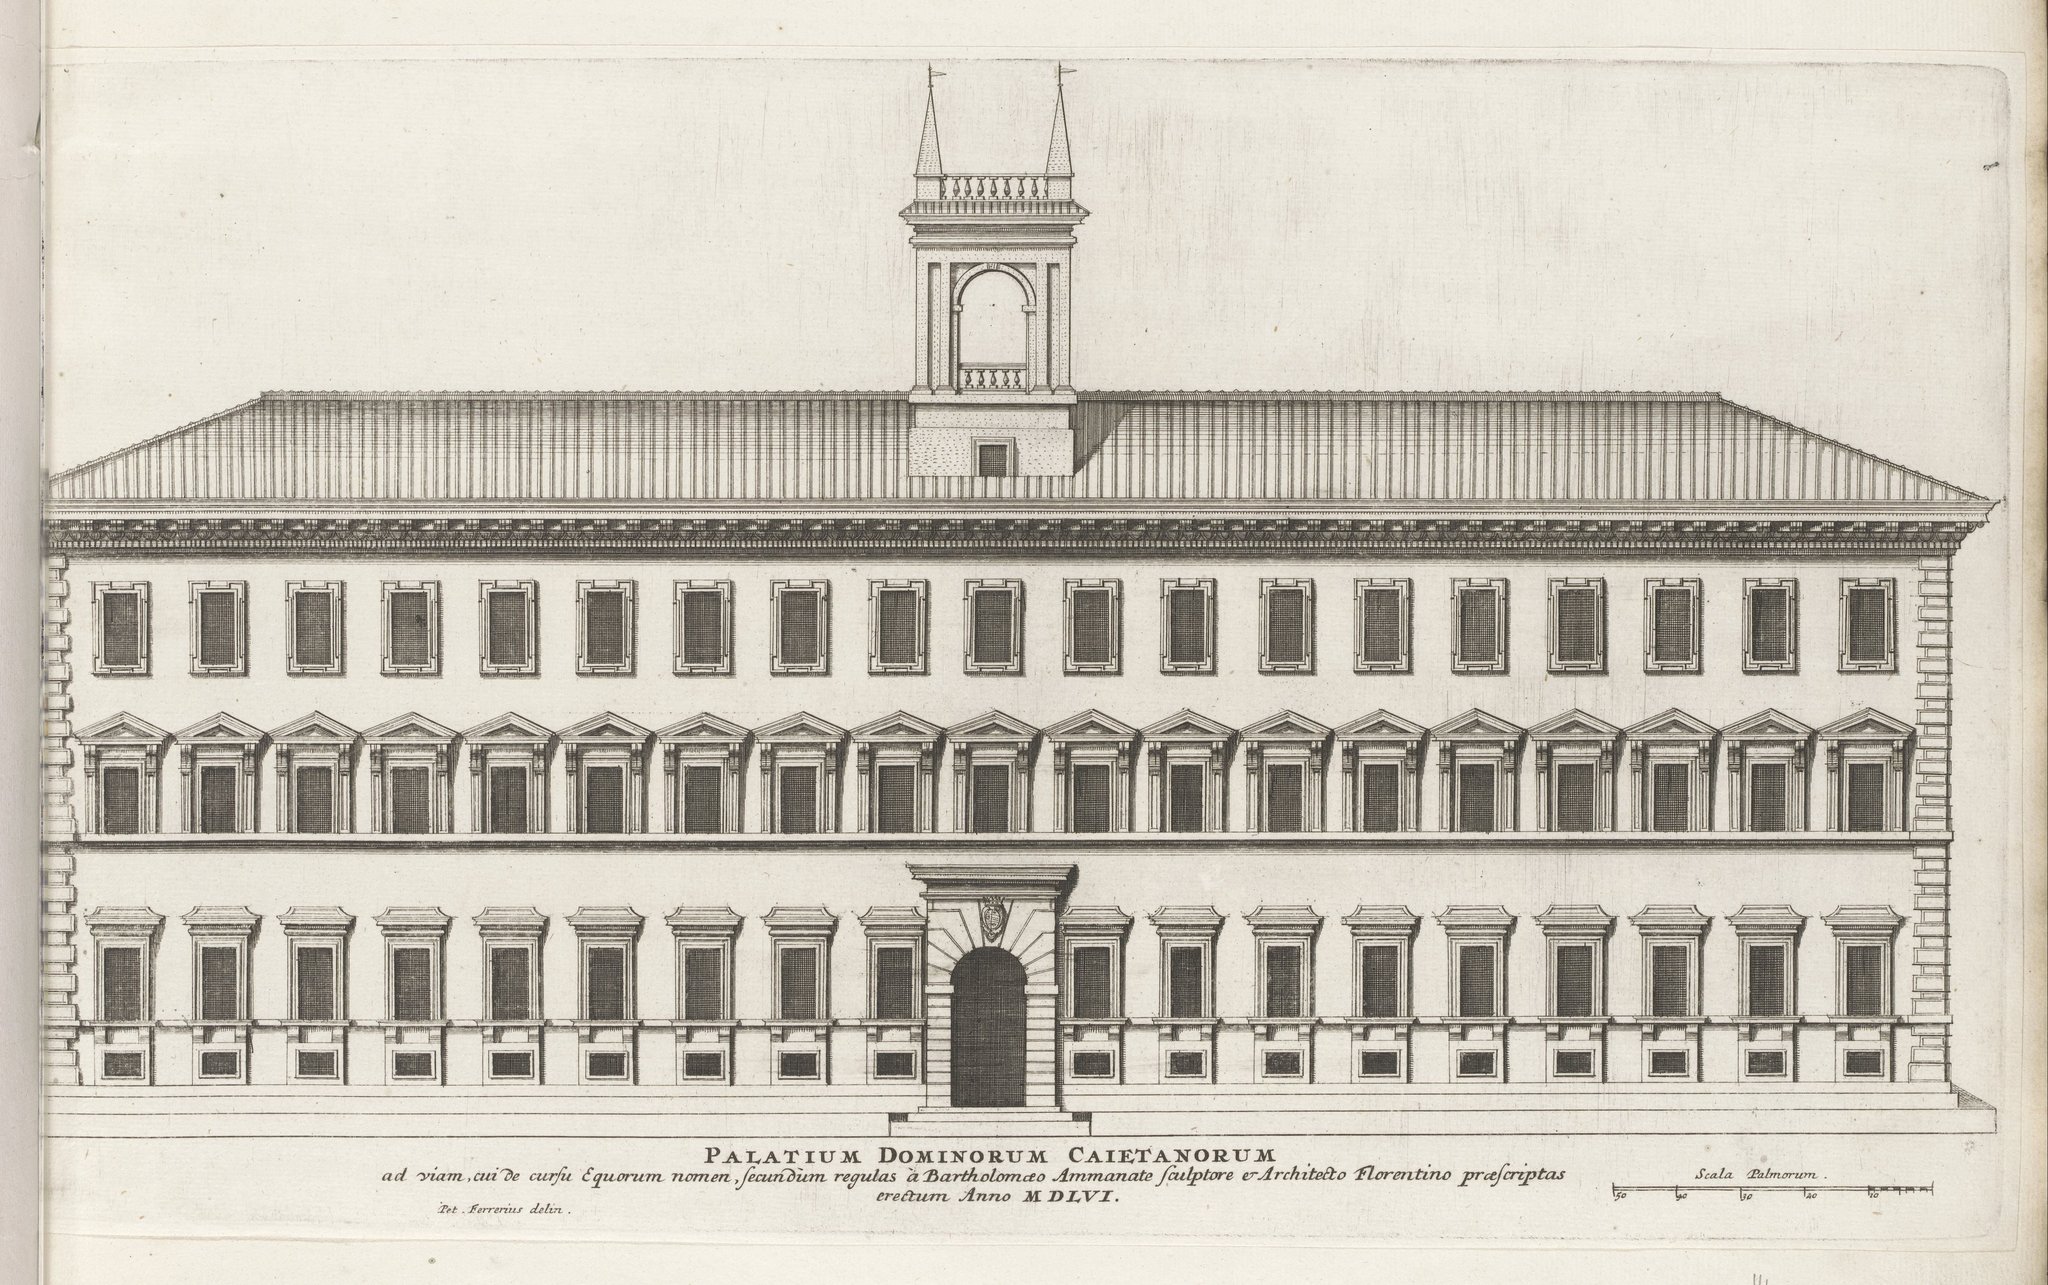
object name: album leaf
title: Romeinse paleizen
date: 1655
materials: paper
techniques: etching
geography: italy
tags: palace, façade (of house or building)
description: Deze prent maakt deel uit van de reeks getiteld: Palazzi di Roma. Deze reeks bestaat uit twee boeken. Boek één getiteld: Palazzi di Roma dei più celebri architetti..., bestaat uit 44 prenten die worden toegeschreven aan Giovanni Battista Falda (naam staat enkel op prent 27) en uitgegeven door Giovanni Giacomo de'Rossi. Deze 44 prenten zijn bekend in twee staten (met en zonder nummer). Boek twee getiteld: Nuovi disegni dell'architetture... libro secondo, bevat 66 prenten door Giovanni Battista Falda en Simone Felice. Deze 66 prenten zijn bekend in twee staten (met en zonder nummer).